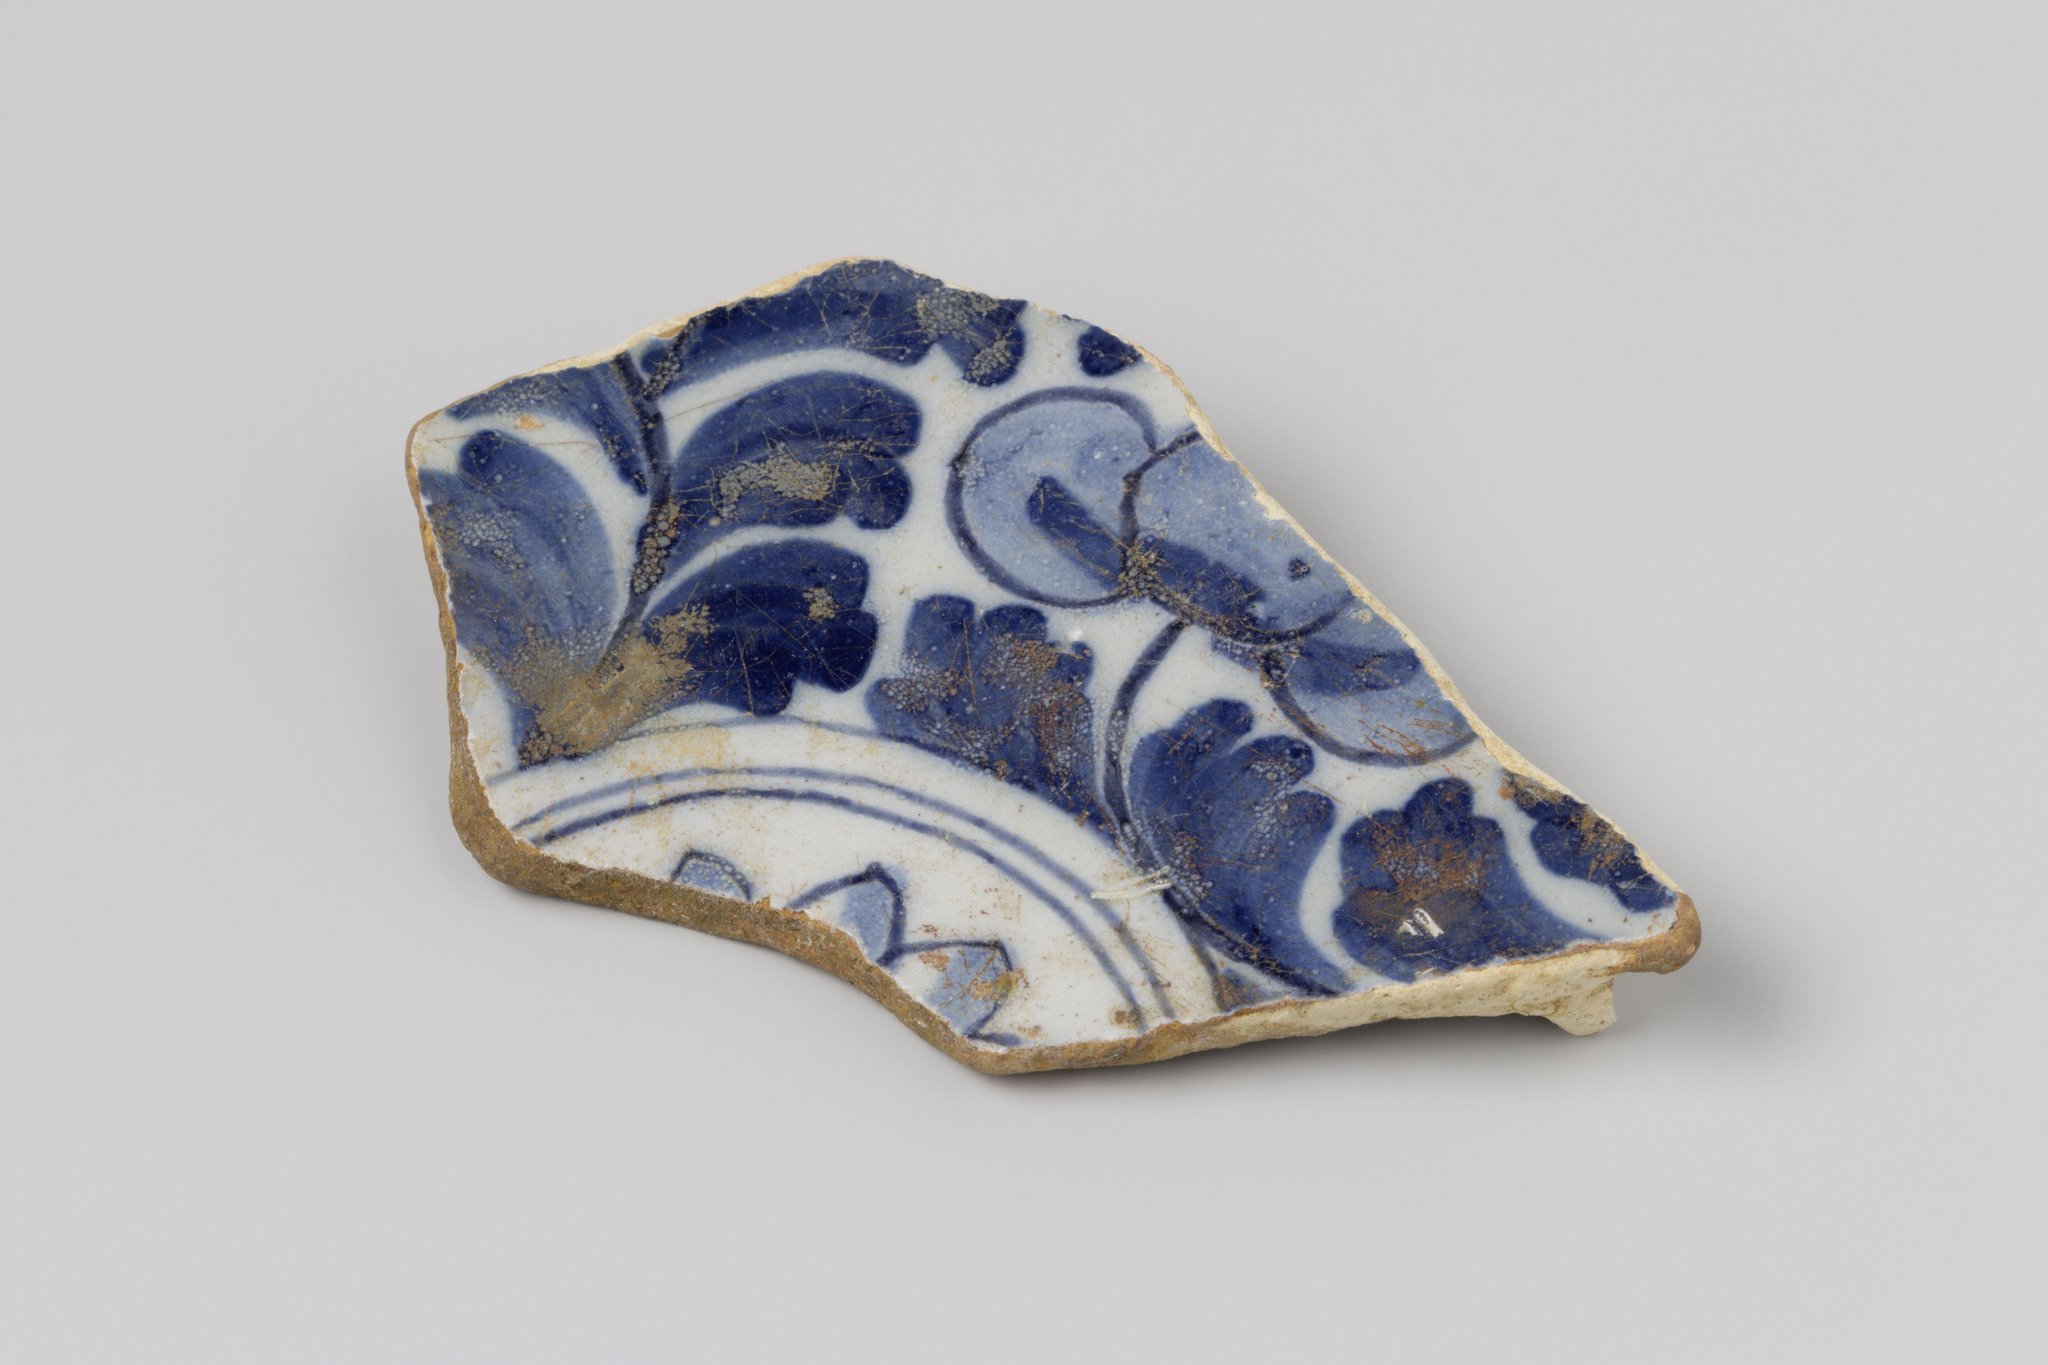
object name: sherd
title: Scherf van een bord uit het wrak van de Oost-Indiëvaarder Hollandia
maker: Anonymous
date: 1700-1743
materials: faience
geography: netherlands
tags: verenigde oostindische compagnie, hollandia (schip), annet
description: Faience (tin-glazed) plate; fragm of base, flat, with circular footring, blue decoration inside of floral motifs.